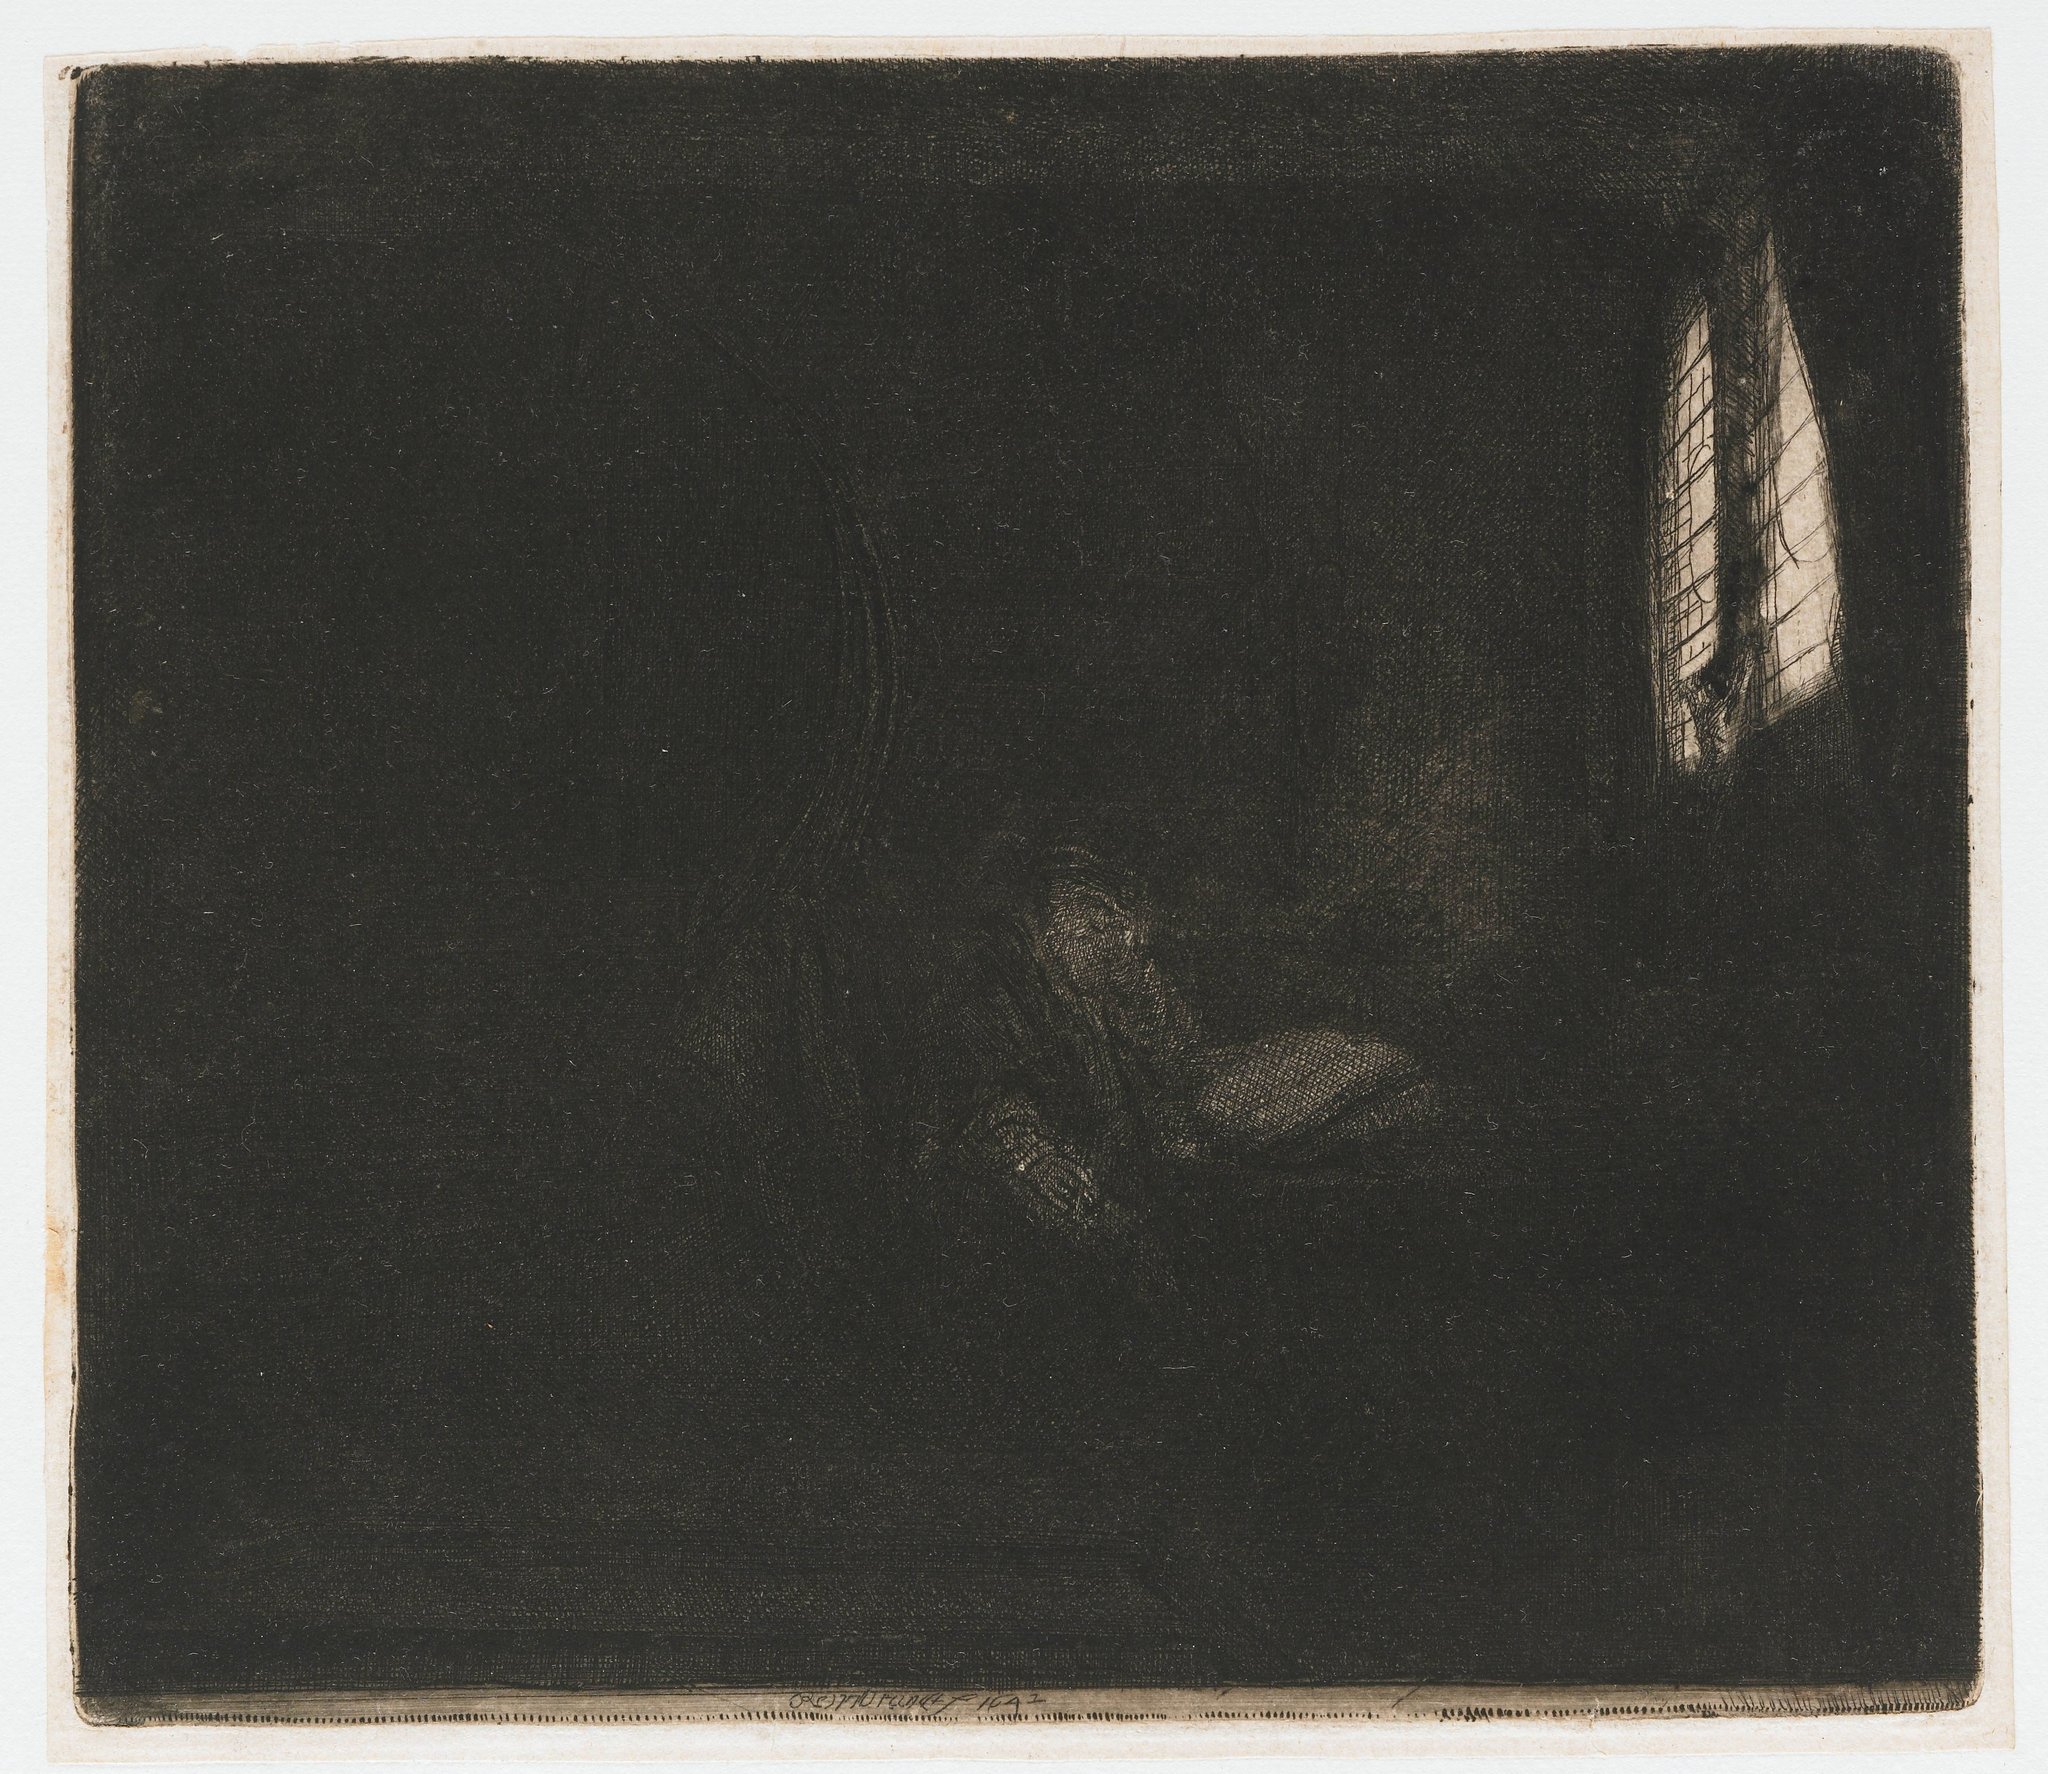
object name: print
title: St Jerome in a dark chamber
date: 1642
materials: paper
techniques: etching, intaglio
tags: the monk and hermit jerome (hieronymus); possible attributes: book, cardinal's hat, crucifix, hour-glass, lion, skull, stone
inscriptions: signature and date: ‘Rembrandt f. 1642’, collector's mark: Lugt 240